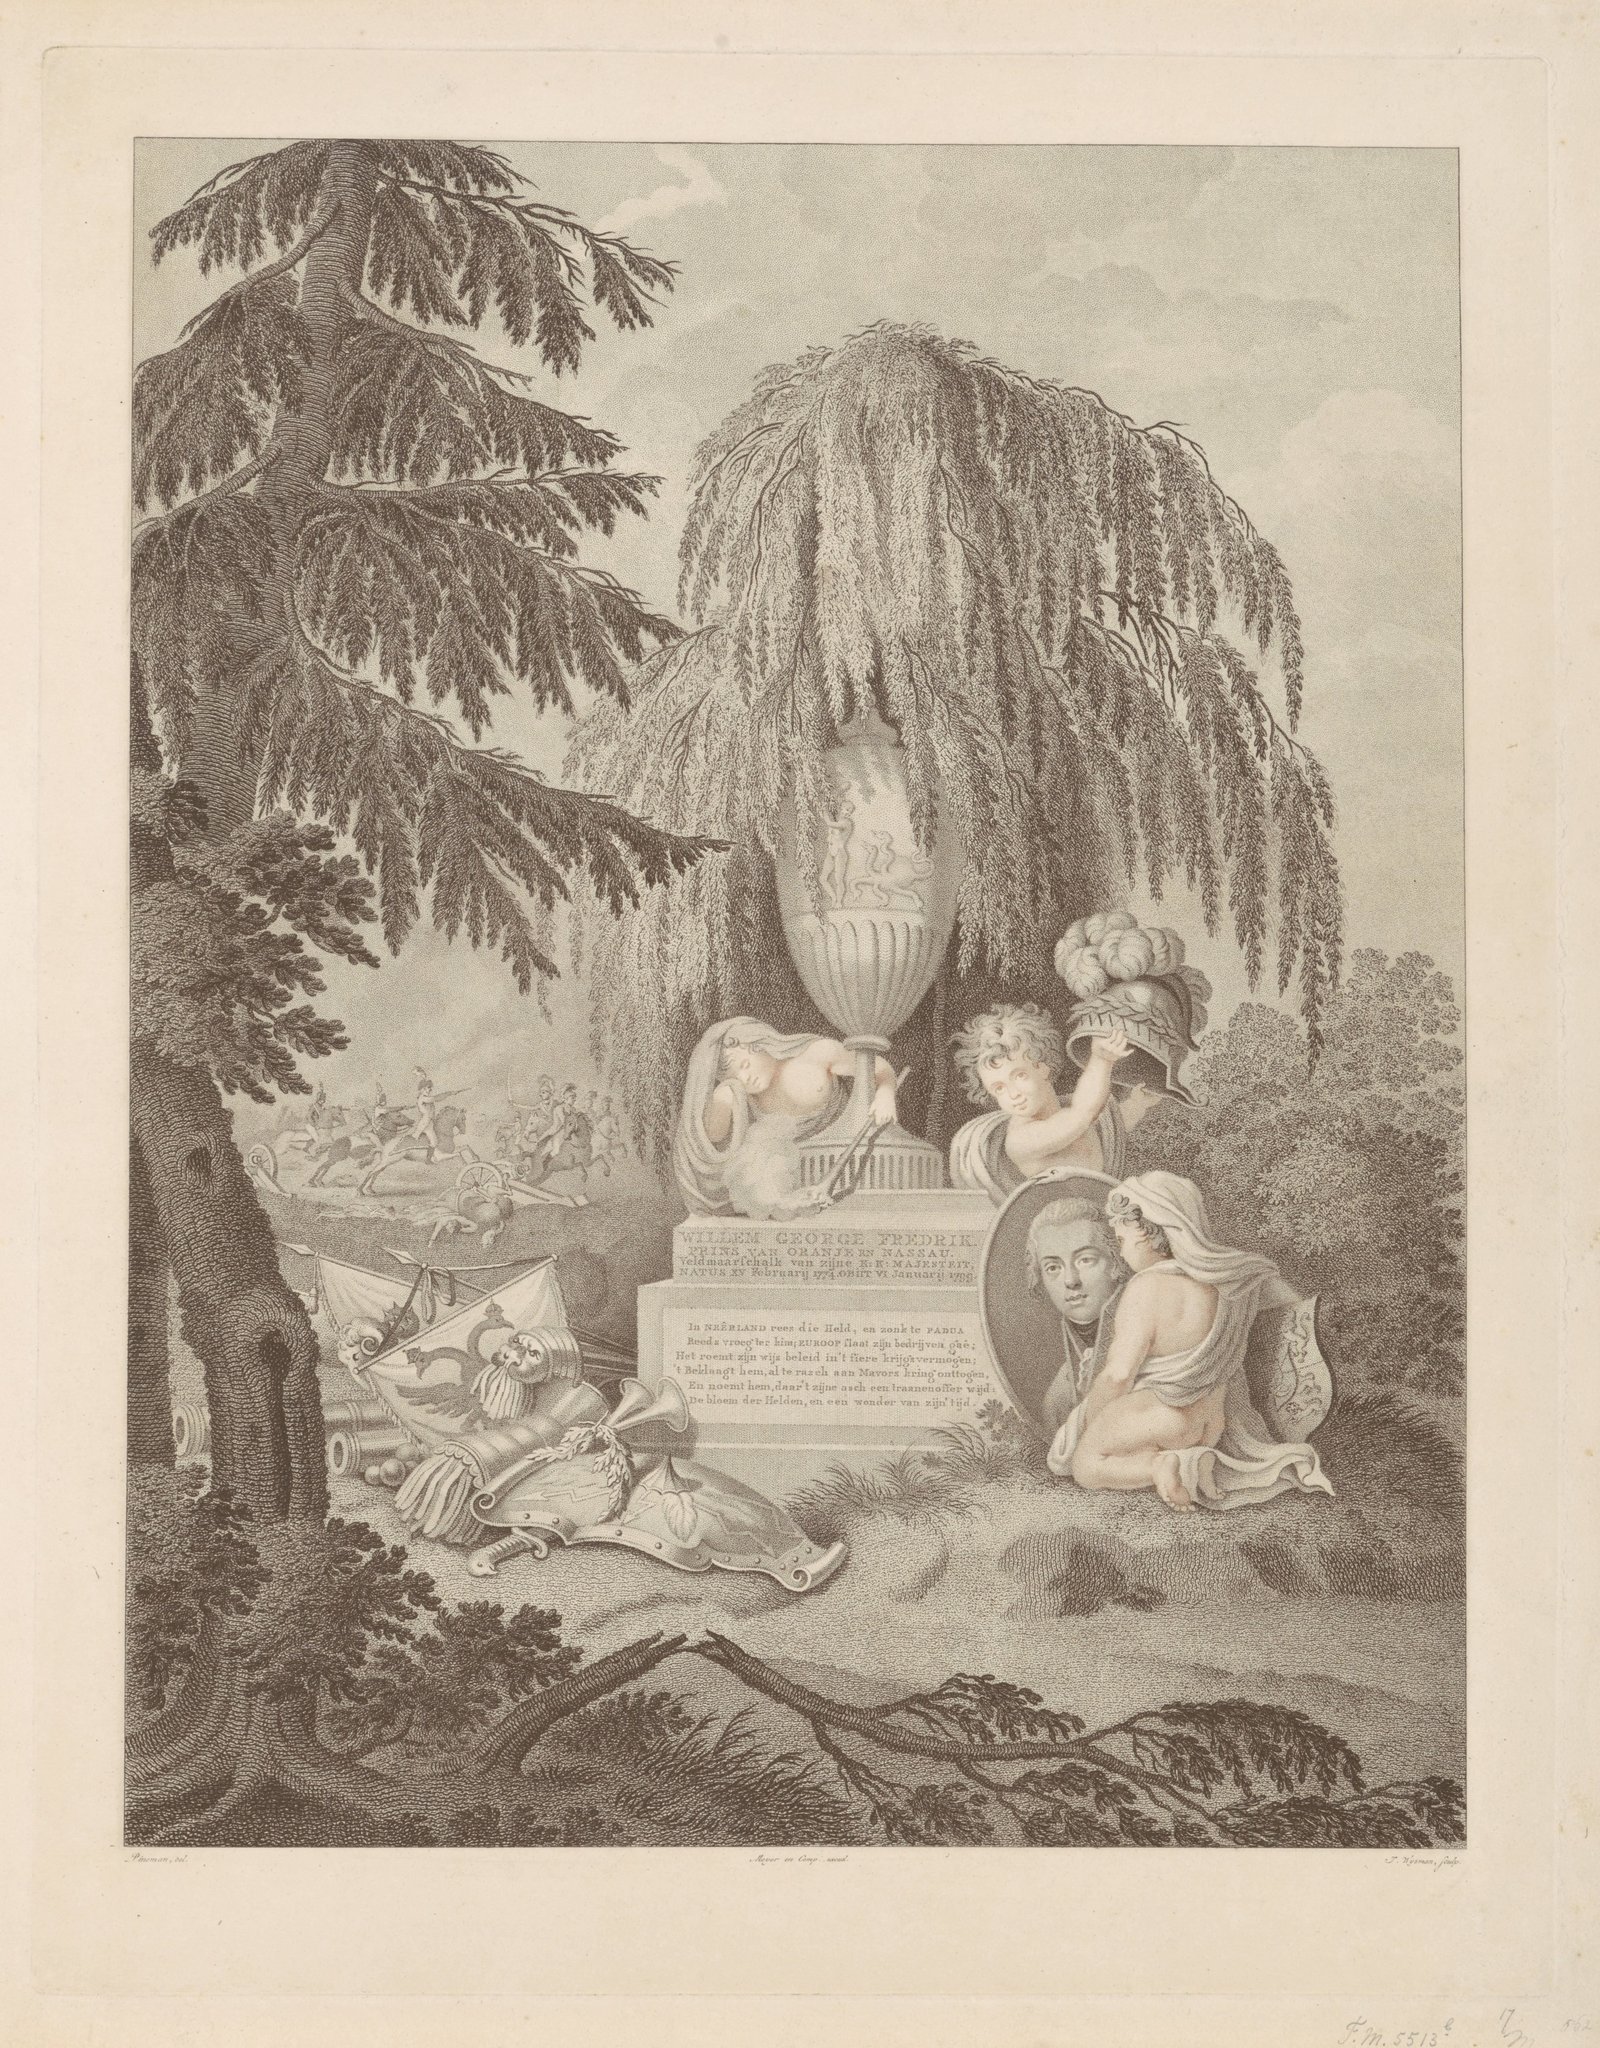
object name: print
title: Allegorisch gedenkteken voor Willem George Frederik, prins van Oranje-Nassau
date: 1799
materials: paper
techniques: etching, lithography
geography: amsterdam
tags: the hague, willem george frederik (prins van oranje-nassau), torch - bb - torch held upside down, grave-building, monumental tomb, cupids: 'amores', 'amoretti', 'putti'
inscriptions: collector's mark: Lugt 963, collector's mark: Lugt 2228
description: Allegorisch gedenkteken voor Willem George Frederik, prins van Oranje-Nassau, overleden te Padua, 6 januari 1799. Bij een door een treurwilg overschaduwd monument staat een treurende putto met een gedoofde toorts. Een andere putto toont een helm en de derde zit bij het portret. Op de grond voor het monument een wapenrusting en vaandels, op de achtergrond een ruitergevecht.